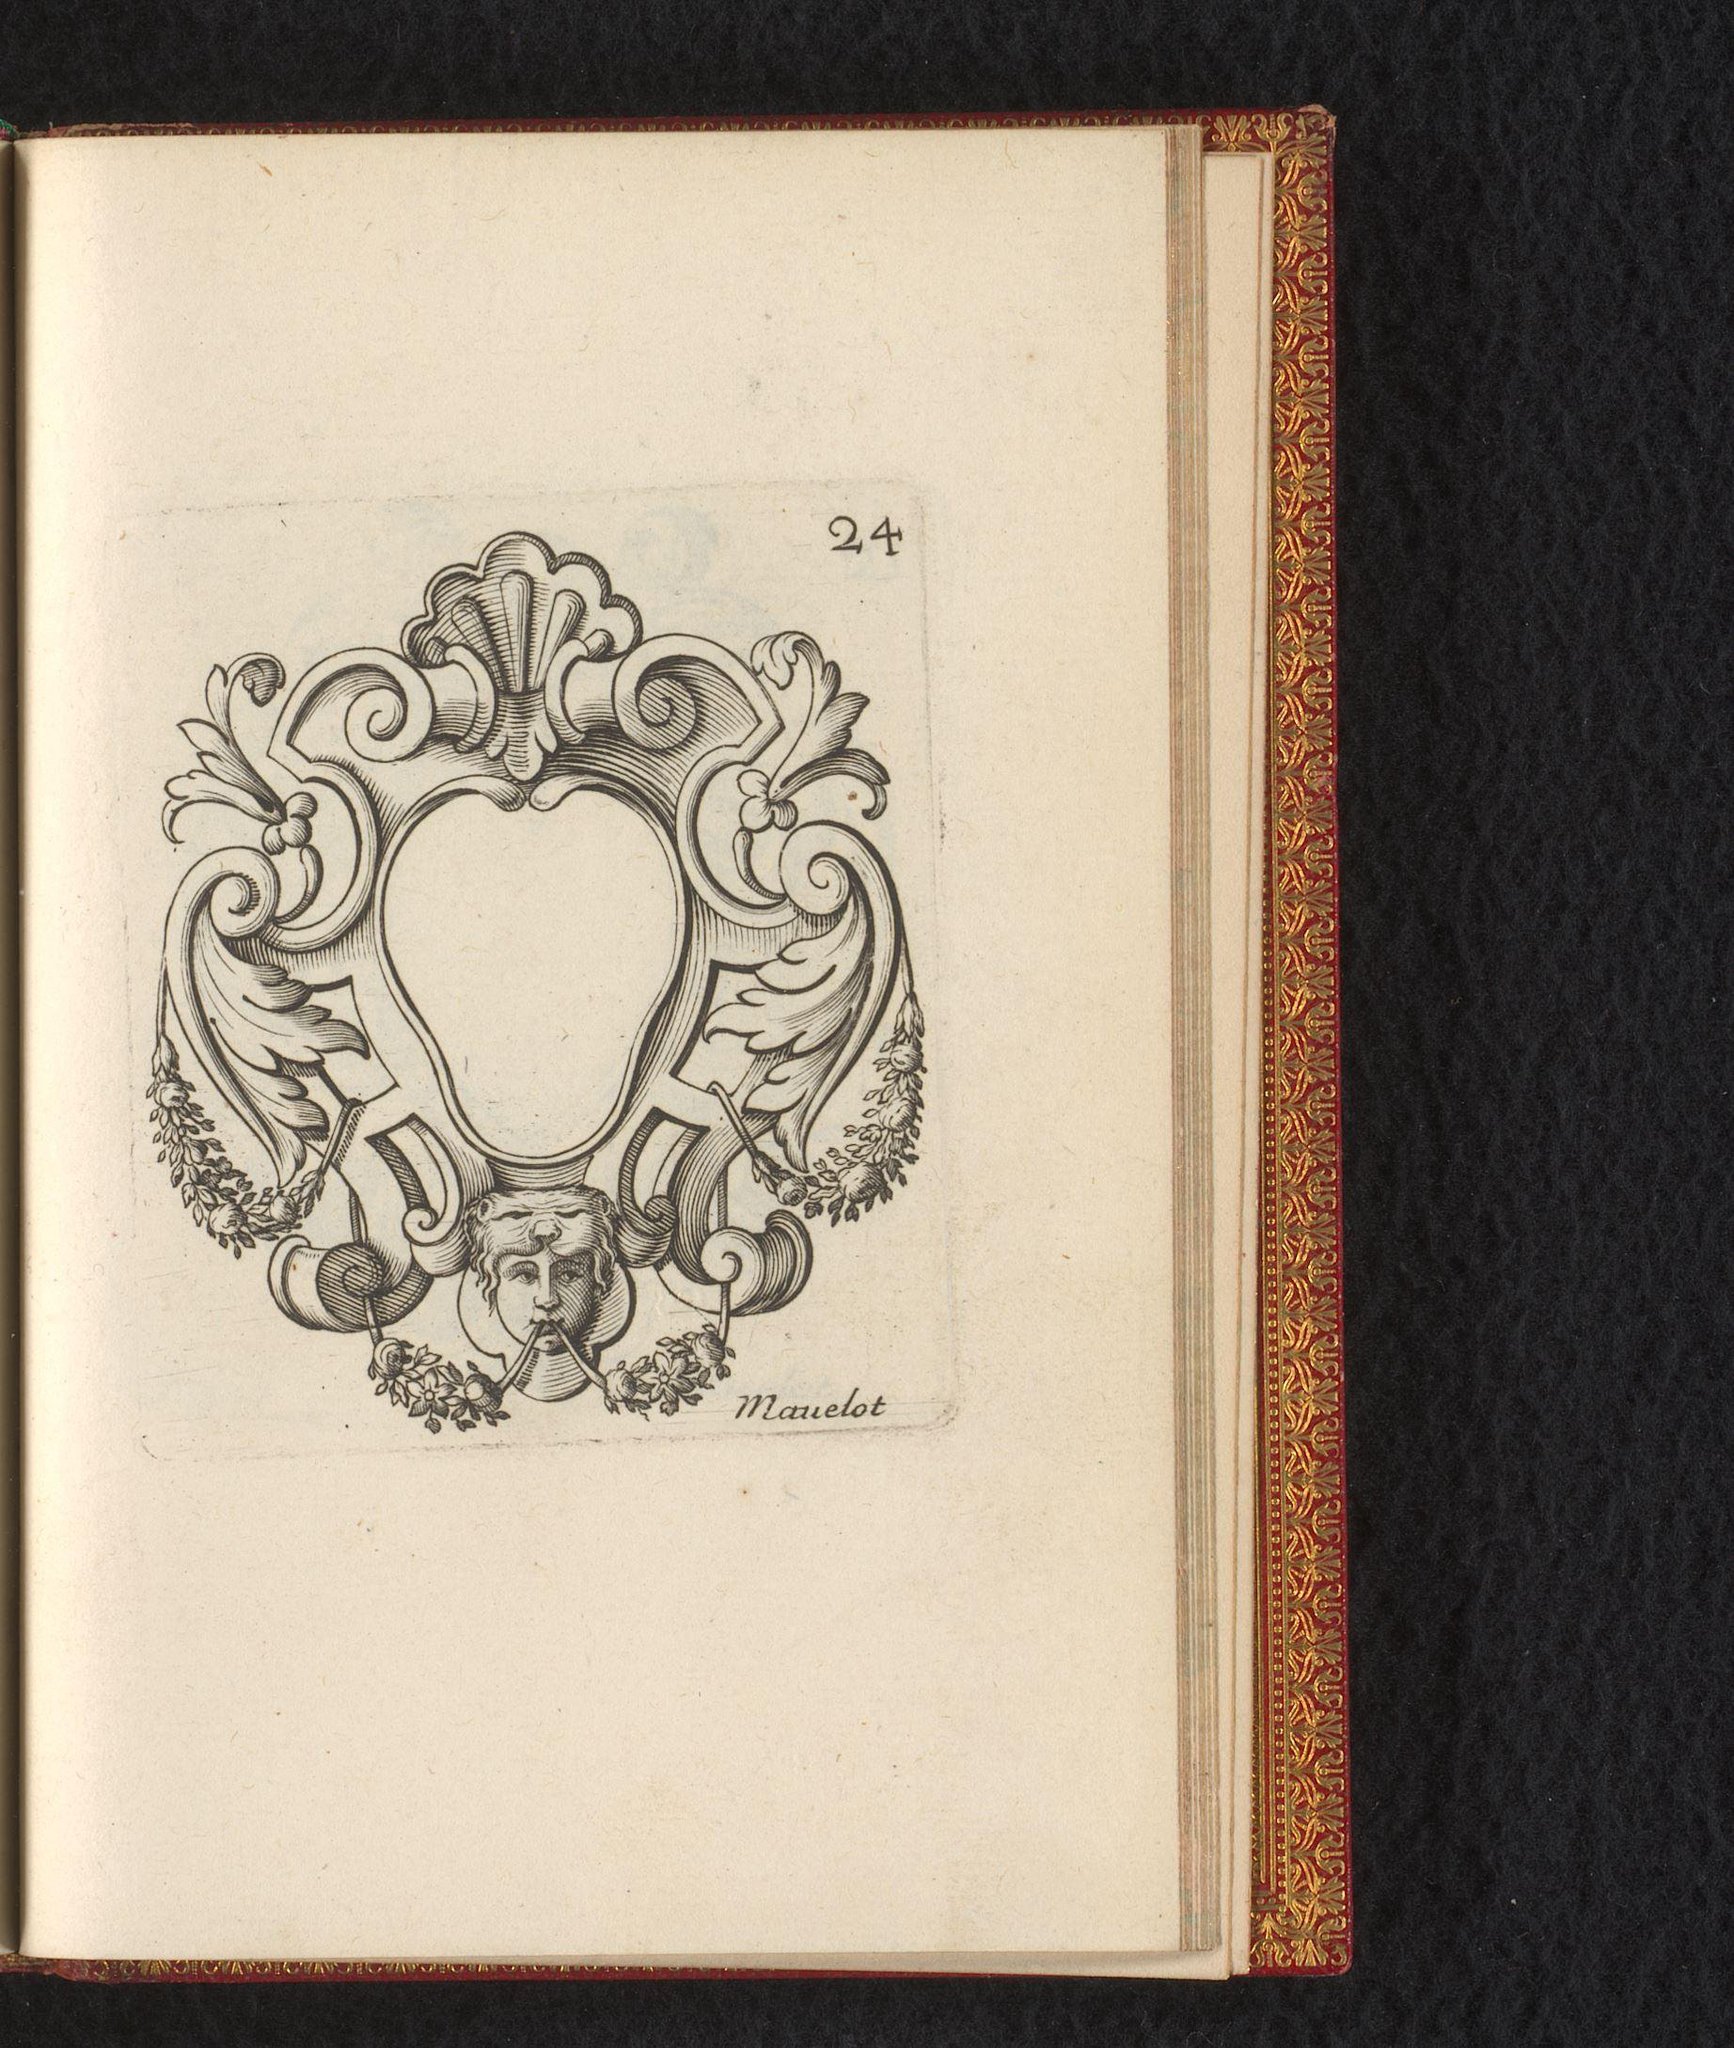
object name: album leaf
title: Cartouche met mascaron met leeuwenhuid op het hoofd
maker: charles mavelot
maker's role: draughtsman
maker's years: 1680-1742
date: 1685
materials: paper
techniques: engraving, etching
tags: scrollwork, strapwork ~ ornament, ornament ~ cartouche, mask, mascaron ~ ornament, ornament ~ festoon, garland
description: Rechtsboven genummerd: 24. Prent maakt deel uit van een album.